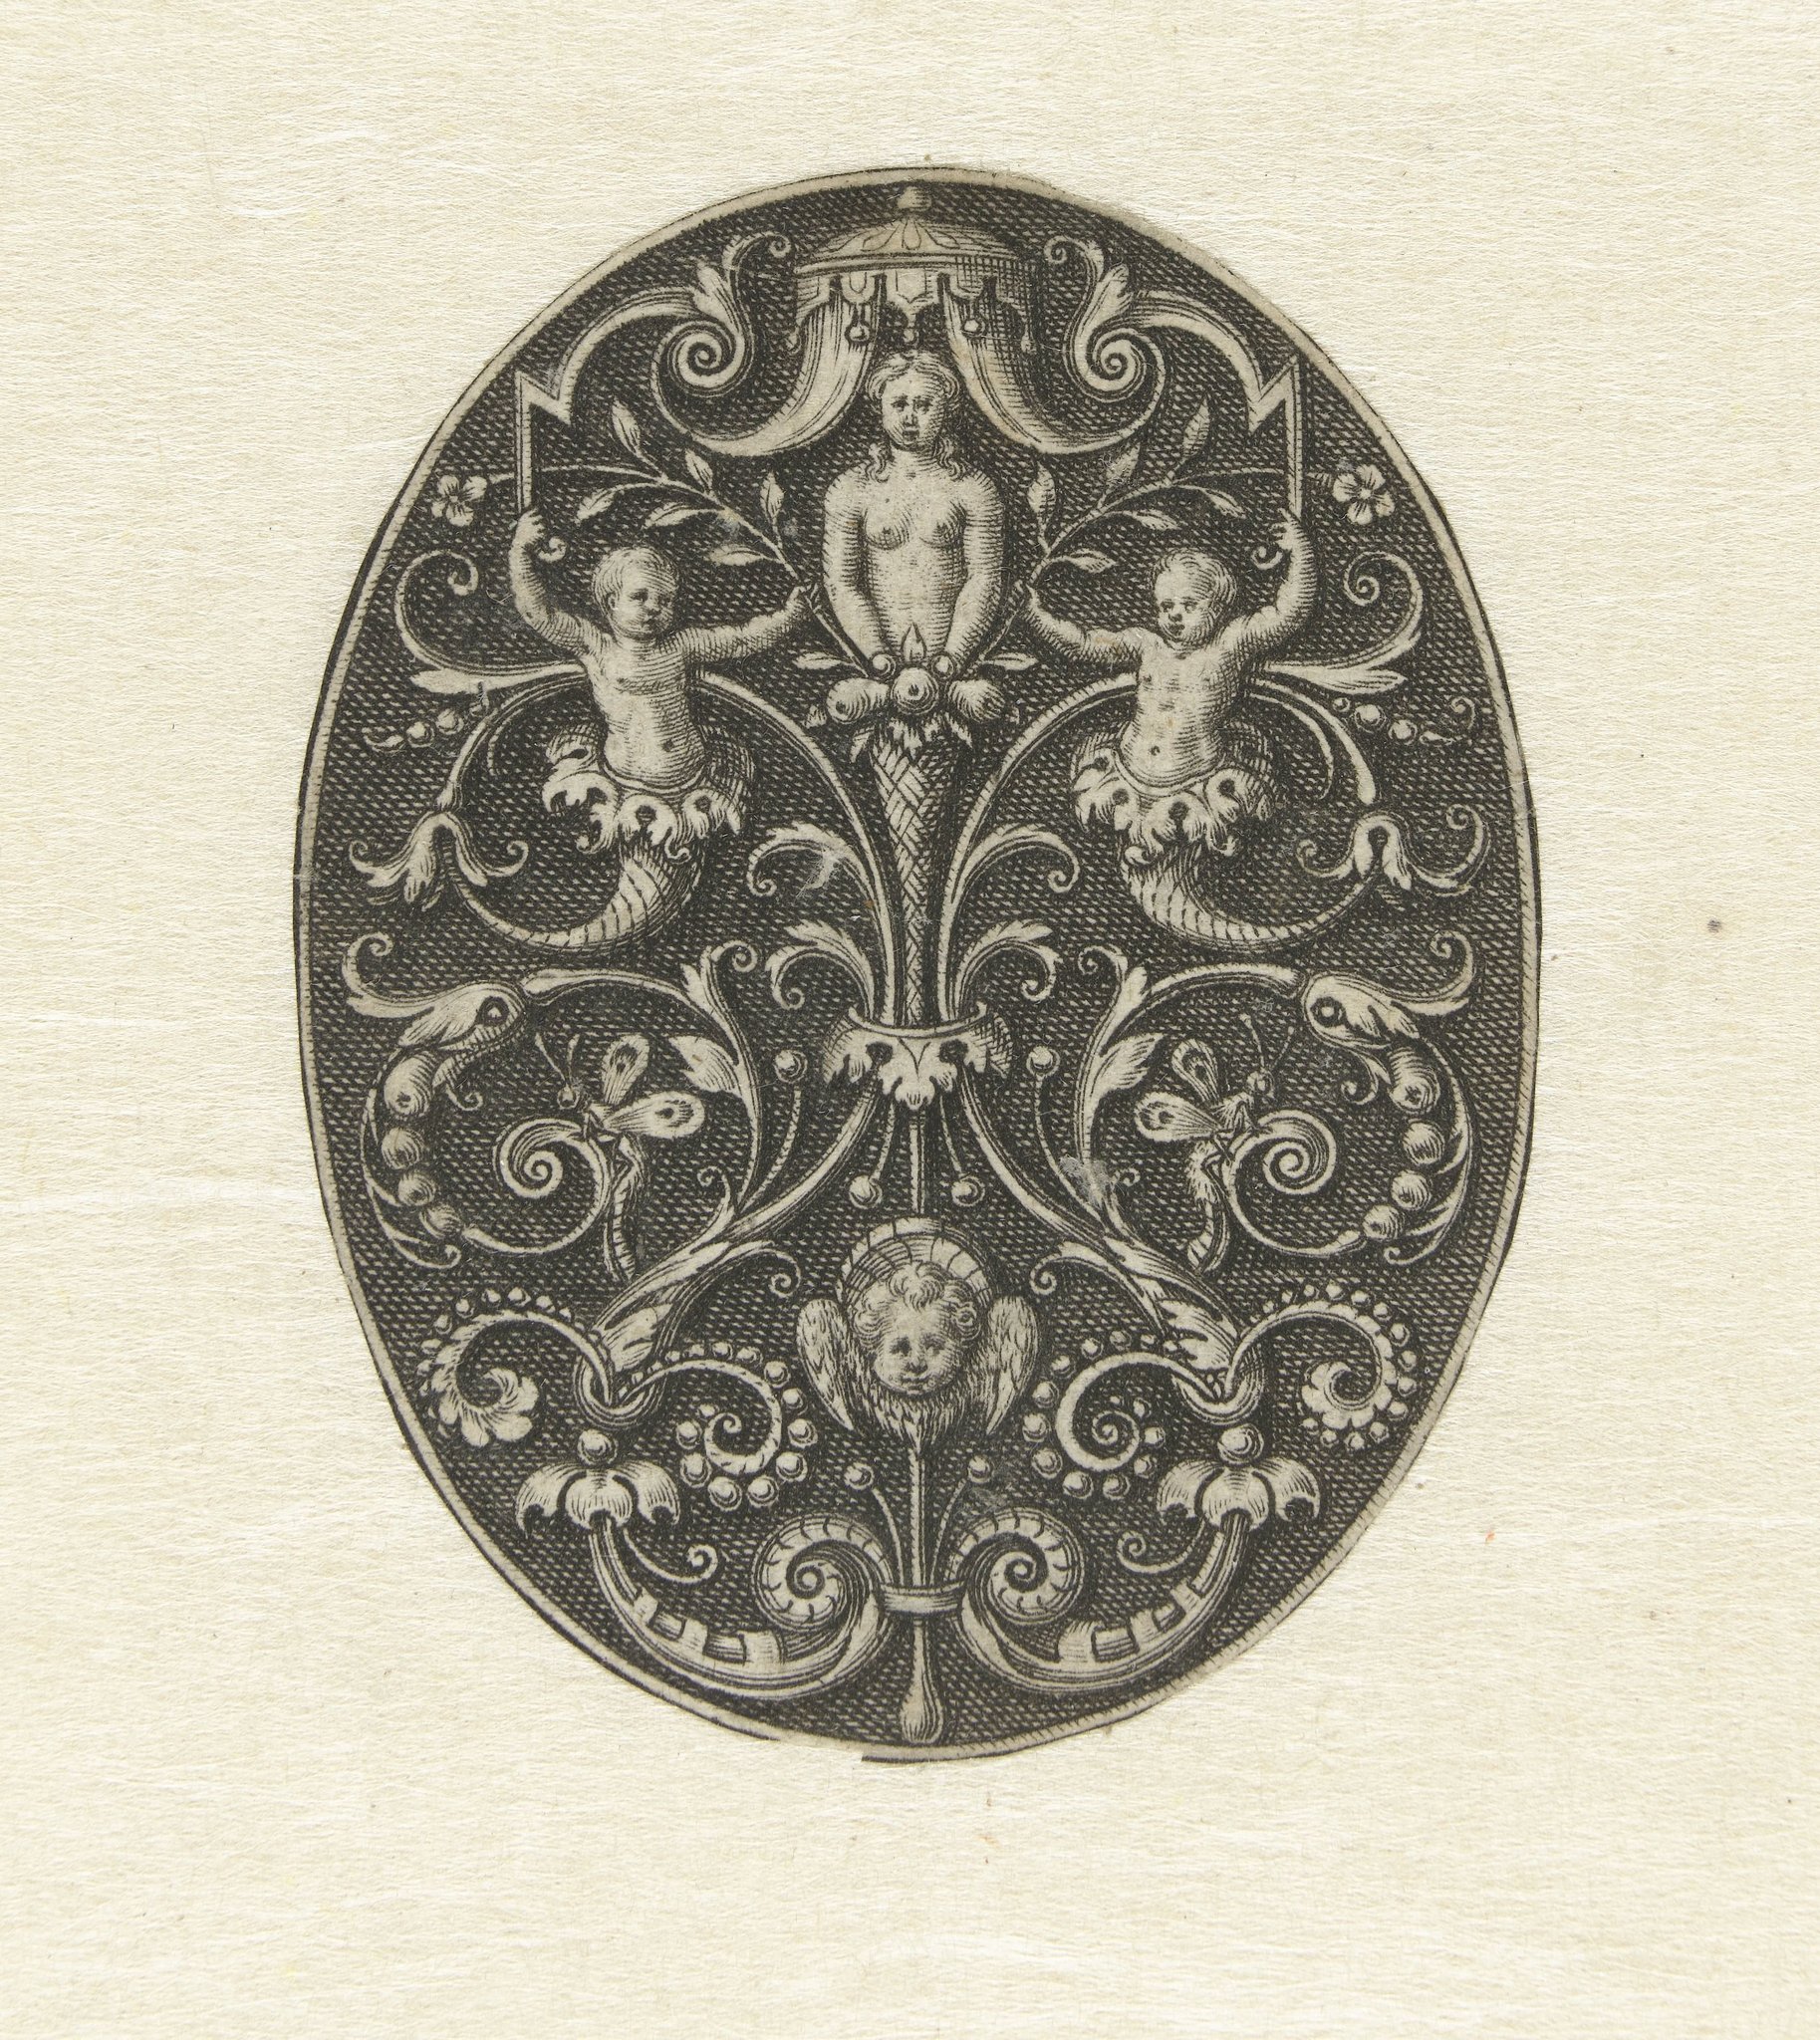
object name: ornament print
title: Ovaal met in het midden een vrouw, aan beide kanten een kind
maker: johann israel de bry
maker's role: print maker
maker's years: 1565-1609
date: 1571-1623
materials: paper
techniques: engraving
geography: germany